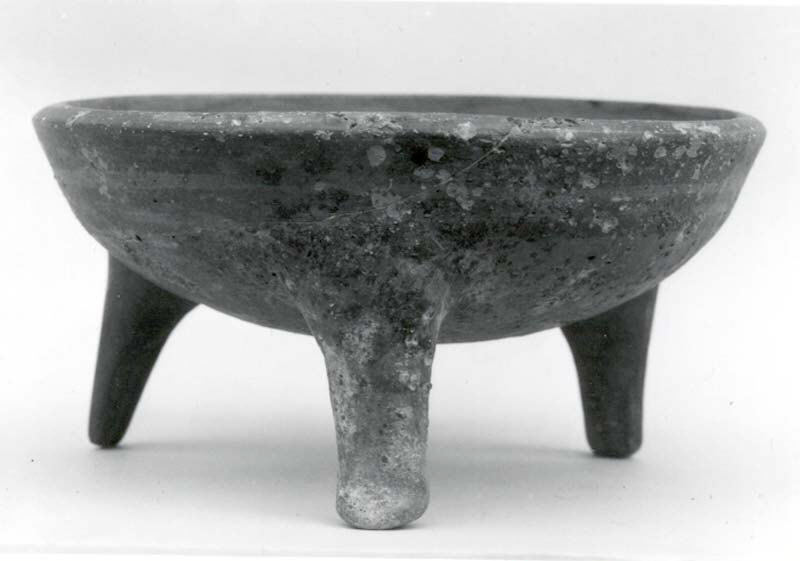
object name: bowl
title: Tripod bowl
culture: iranian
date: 2000-1600 BCE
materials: ceramic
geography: iran, luristan